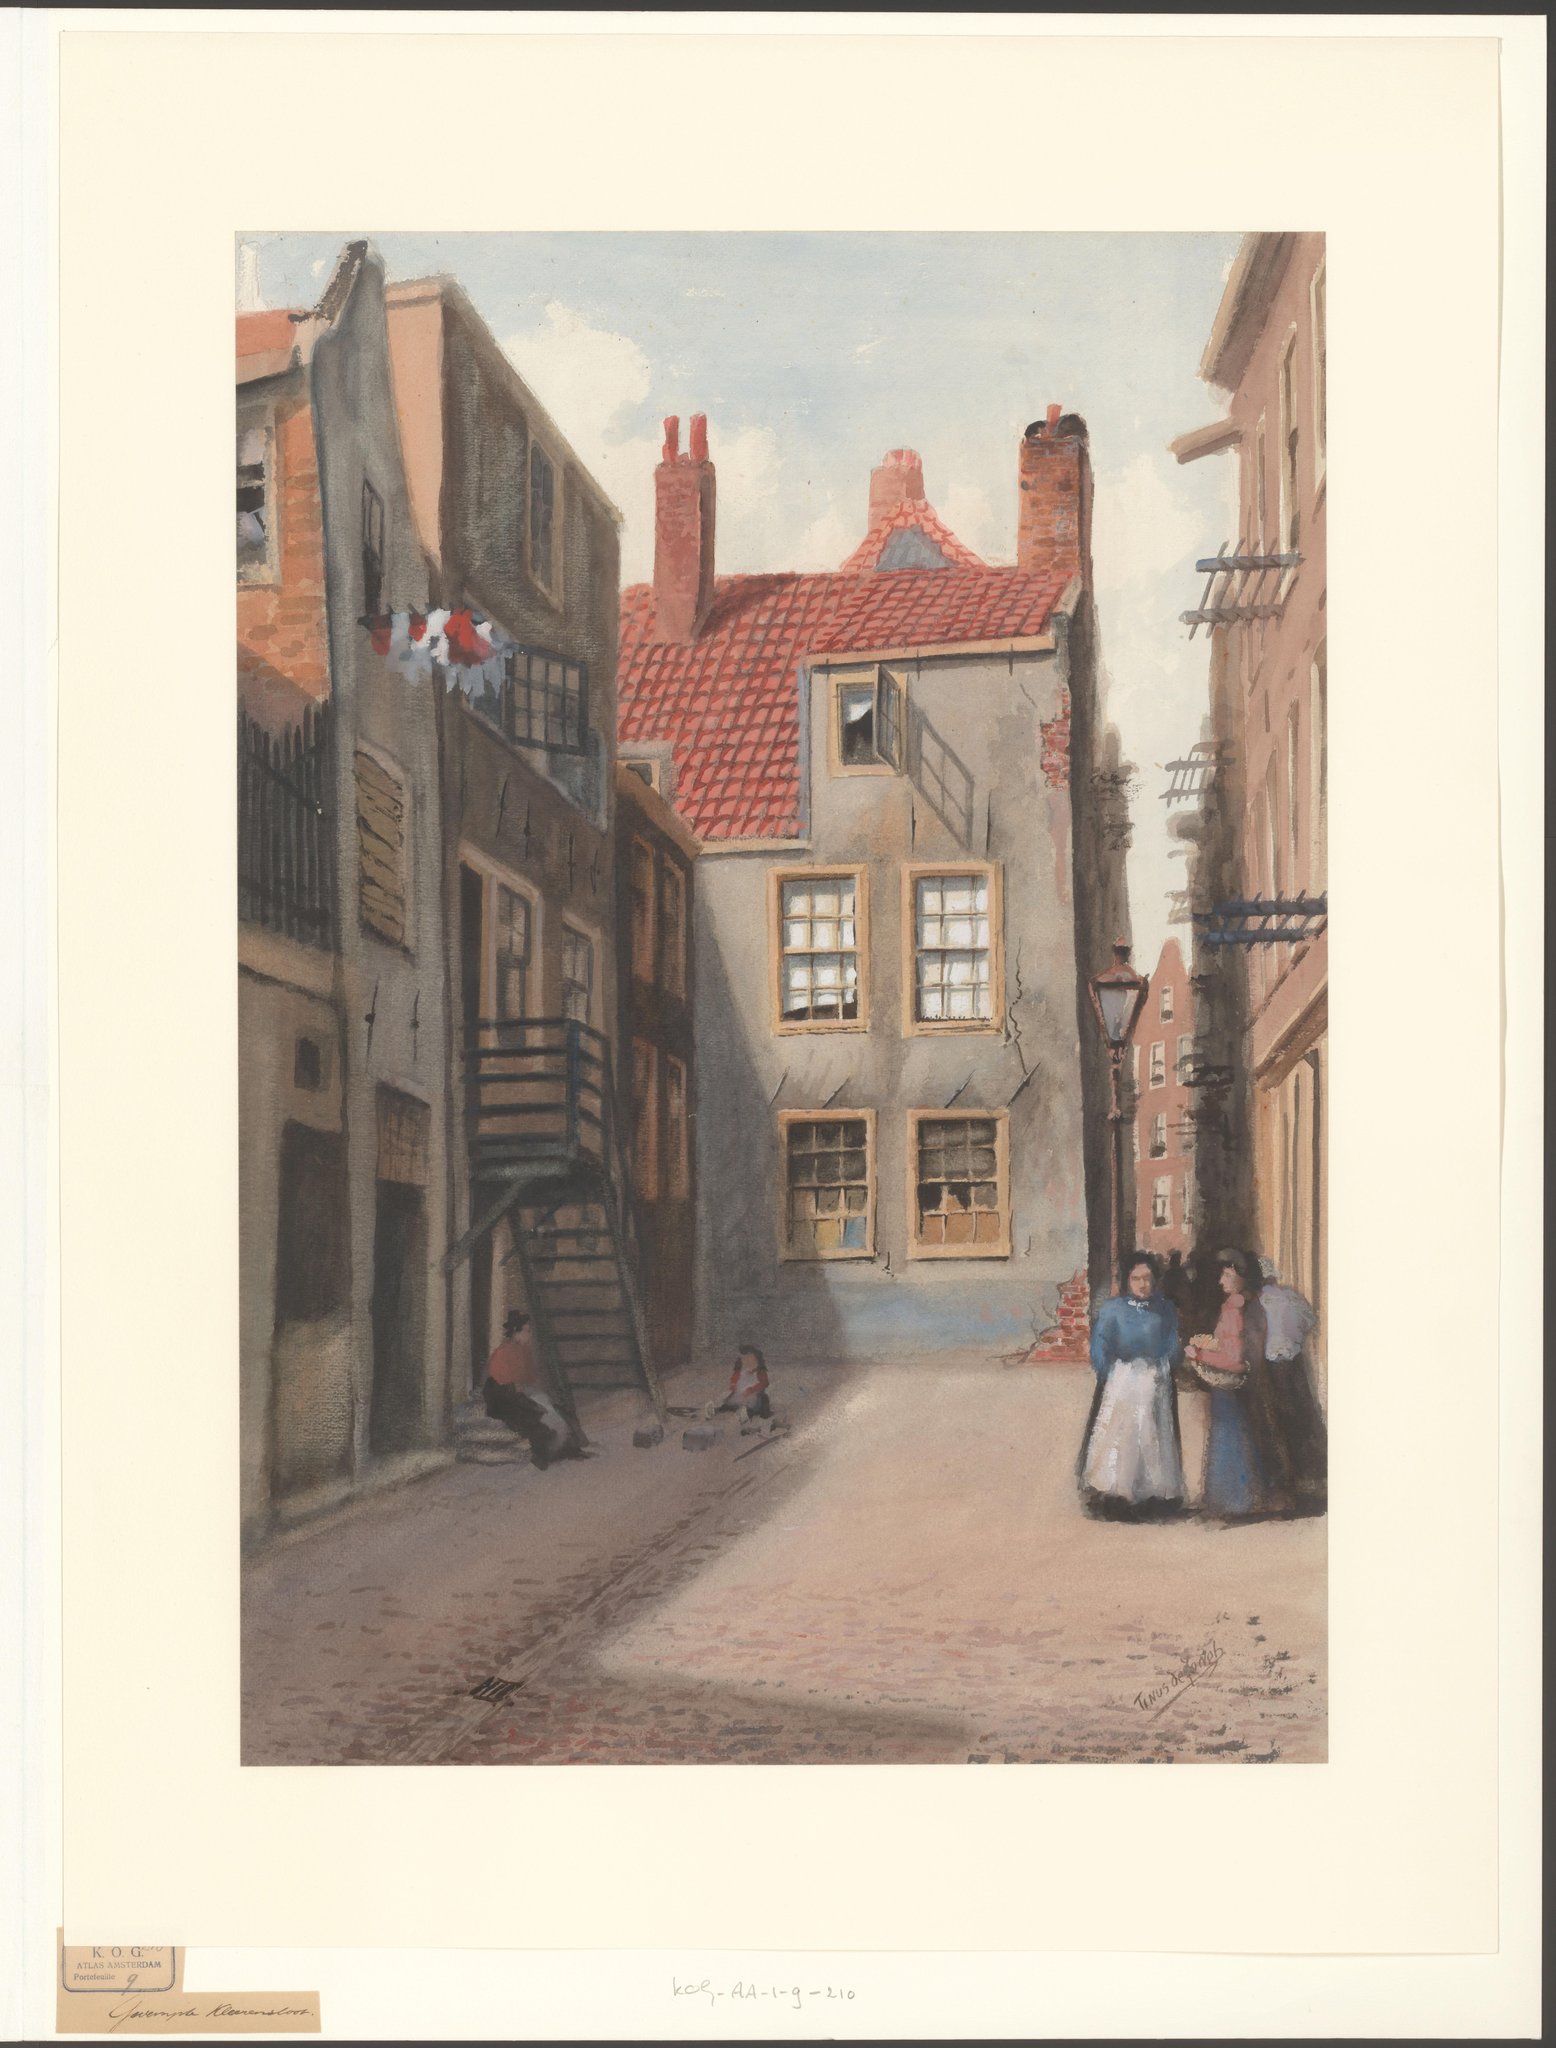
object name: drawing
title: Gezicht op de Kleersloot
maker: tinus de jongh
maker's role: print maker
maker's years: 1885-1942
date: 1895-1942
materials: paint, gouache, paper, pencil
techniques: brush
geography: amsterdam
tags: city-view in general; 'veduta', the usual house or row of houses, lane, alley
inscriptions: inscription: ‘Gedempte Kleerensloot’, inscription: ‘Port. 9-210’, collector's mark: ‘9’ Lugt 1641b, signature: ‘Tinus de Jongh’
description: Onderwerpsrubriek binnen de Atlas Amsterdam: Kadijksplein, Karthuizerkerkhof, Kattegat, Kattenburg, Kapelsteeg O.Z., Enge Kerksteeg, Kerkstraat, Kinkerstraat, Kolk O.Z., Koningsplein, Kromboomsloot [Krom Boomssloot], Kostverlorenkade, Kwakersdwarspad, Kalverstraat, Keizersgracht (v.d. Brouwersgracht – Amstel), Klerensloot (Gedempte), Klimopstraat, Kloveniersburgwal, Kraansluis.